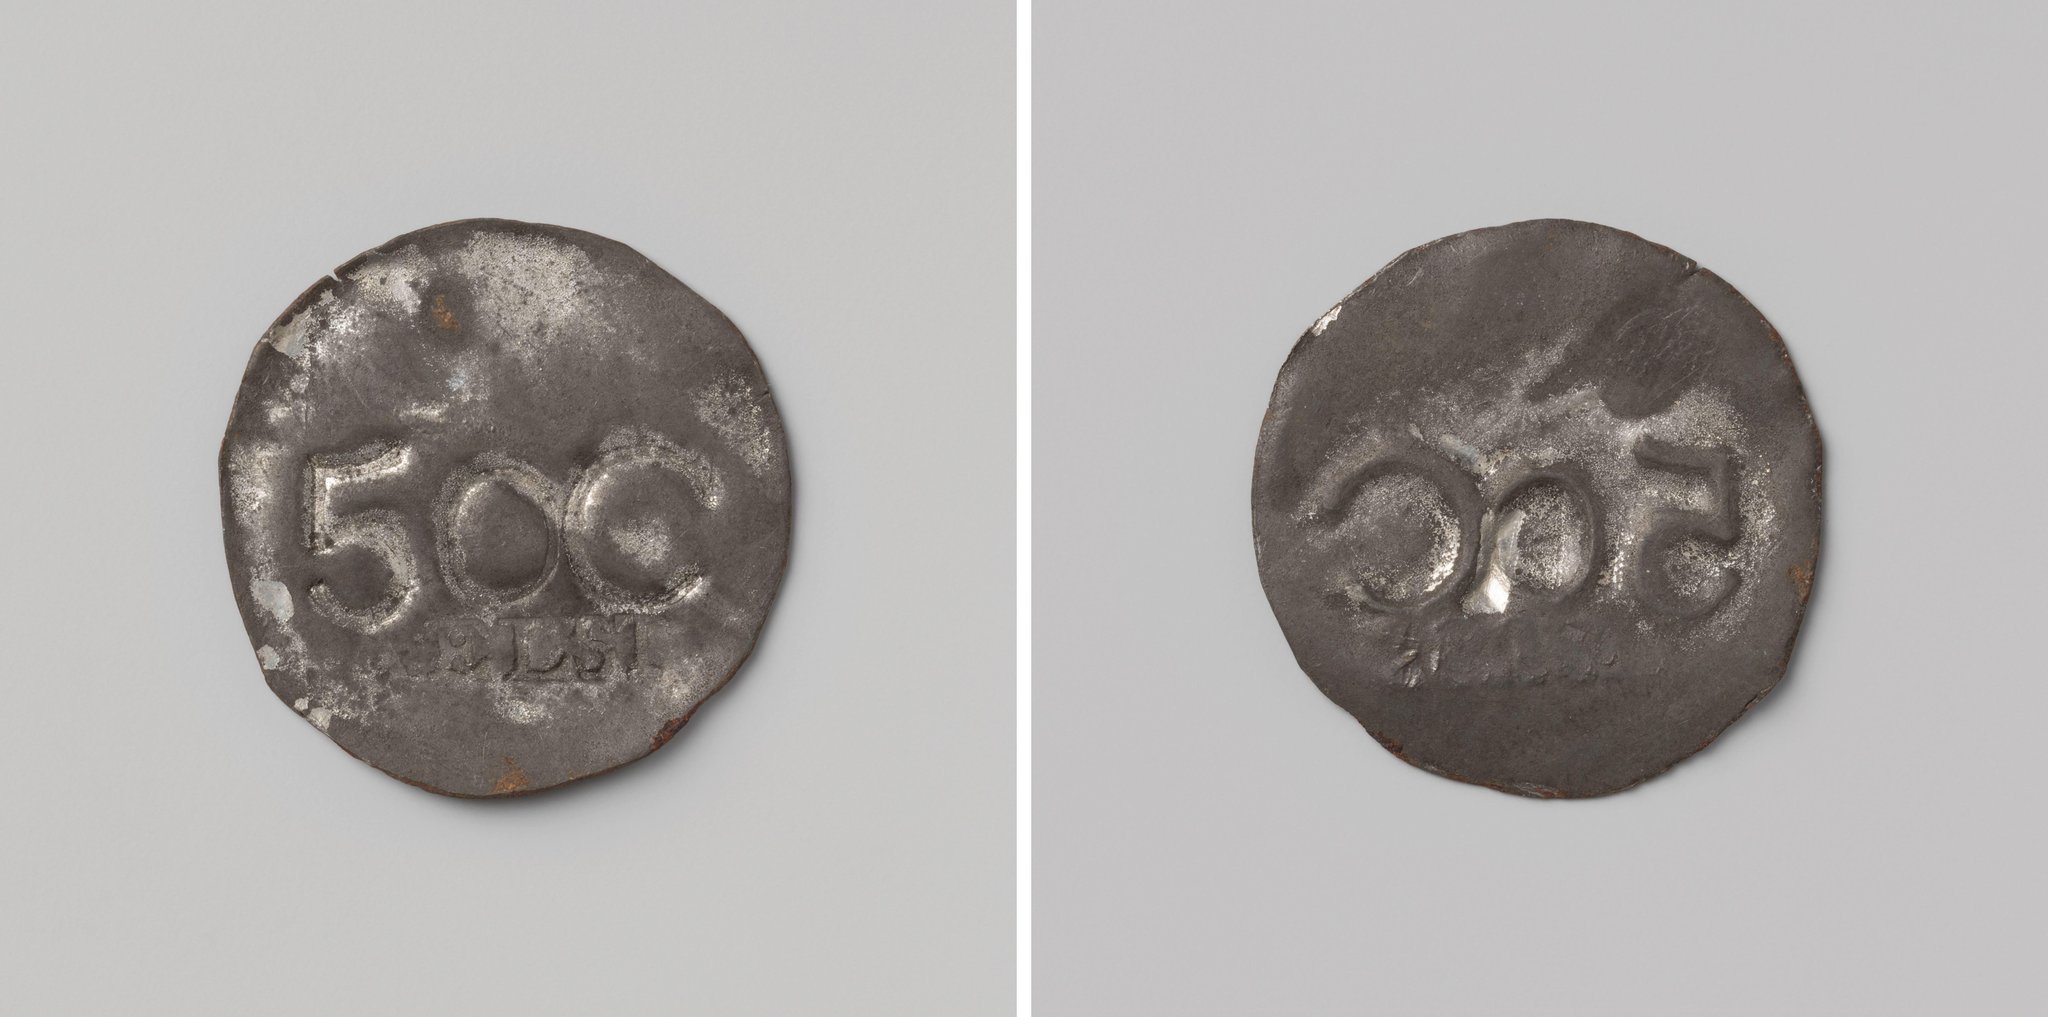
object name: monetary token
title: Strafkolonie Ommerschans(?), huismunt ter waarde van 50 cent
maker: d.a. schretlen junior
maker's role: blikslager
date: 1827-1830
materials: tin, metal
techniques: striking, tinning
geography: leiden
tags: elst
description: Eenzijdige betaalpenning van blik en tin. Voorzijde: waardeaanduiding boven klop: met opschrift 'K ELST'. Keerzijde: blanco.